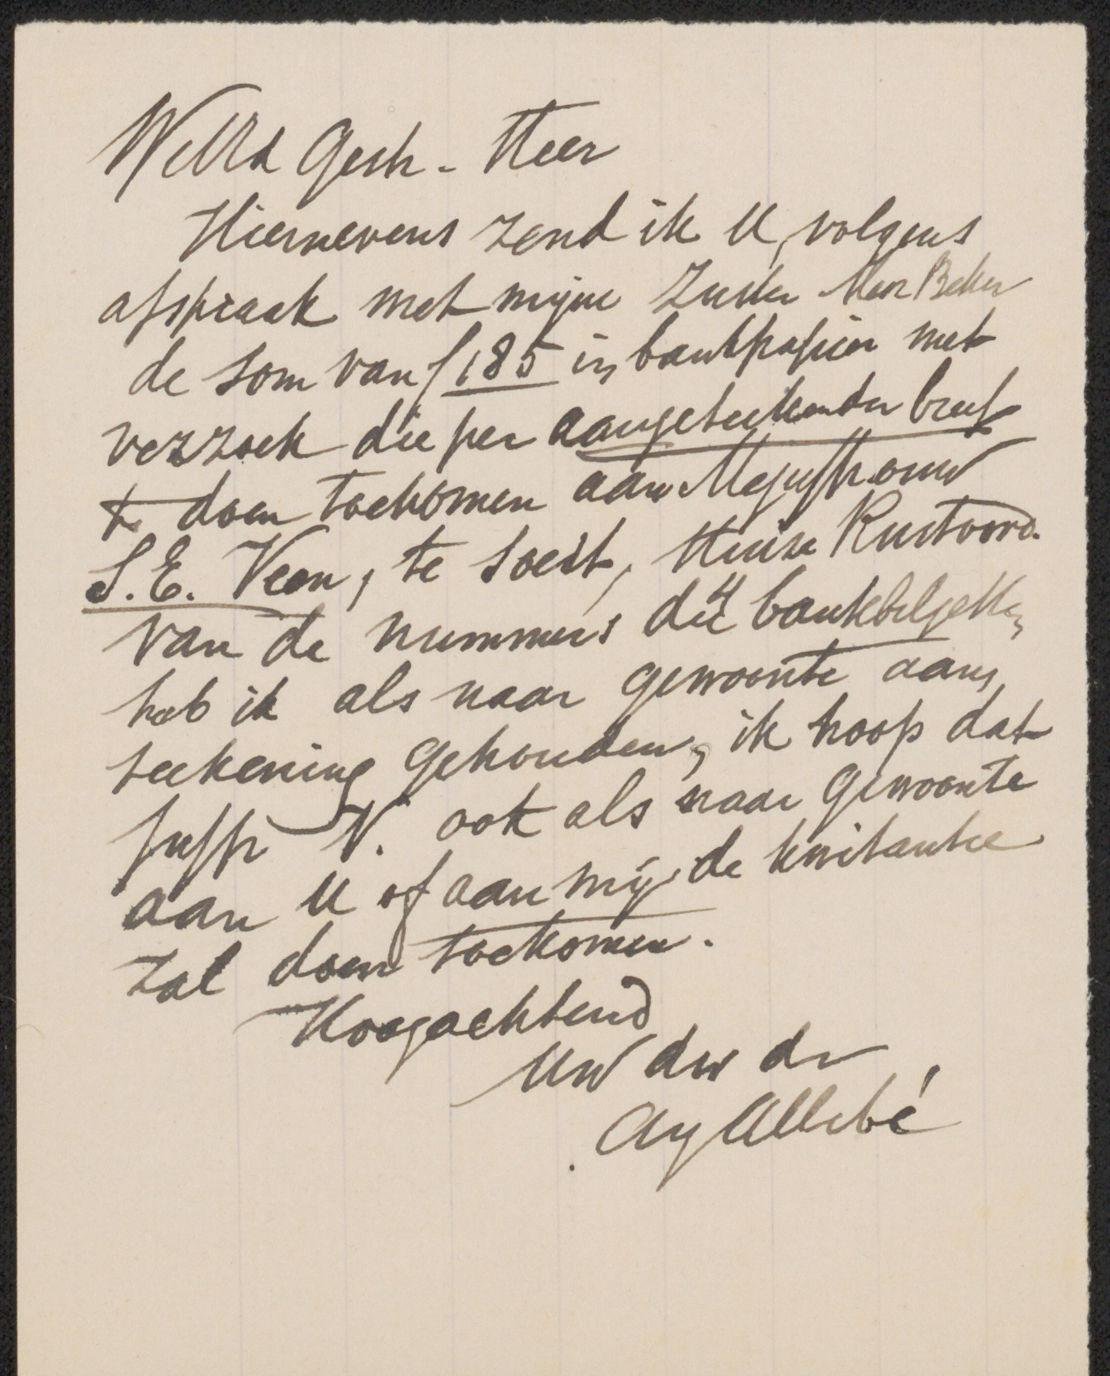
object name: letter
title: Conceptbrief aan anoniem en conceptbrief aan de heer Wierink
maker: august allebé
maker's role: draughtsman, print maker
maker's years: 1838-1927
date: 1848-1927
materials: ink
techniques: pen, writing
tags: dordrecht, amsterdam, painter, print maker, draughtsman, designer, jan veth, family life, money